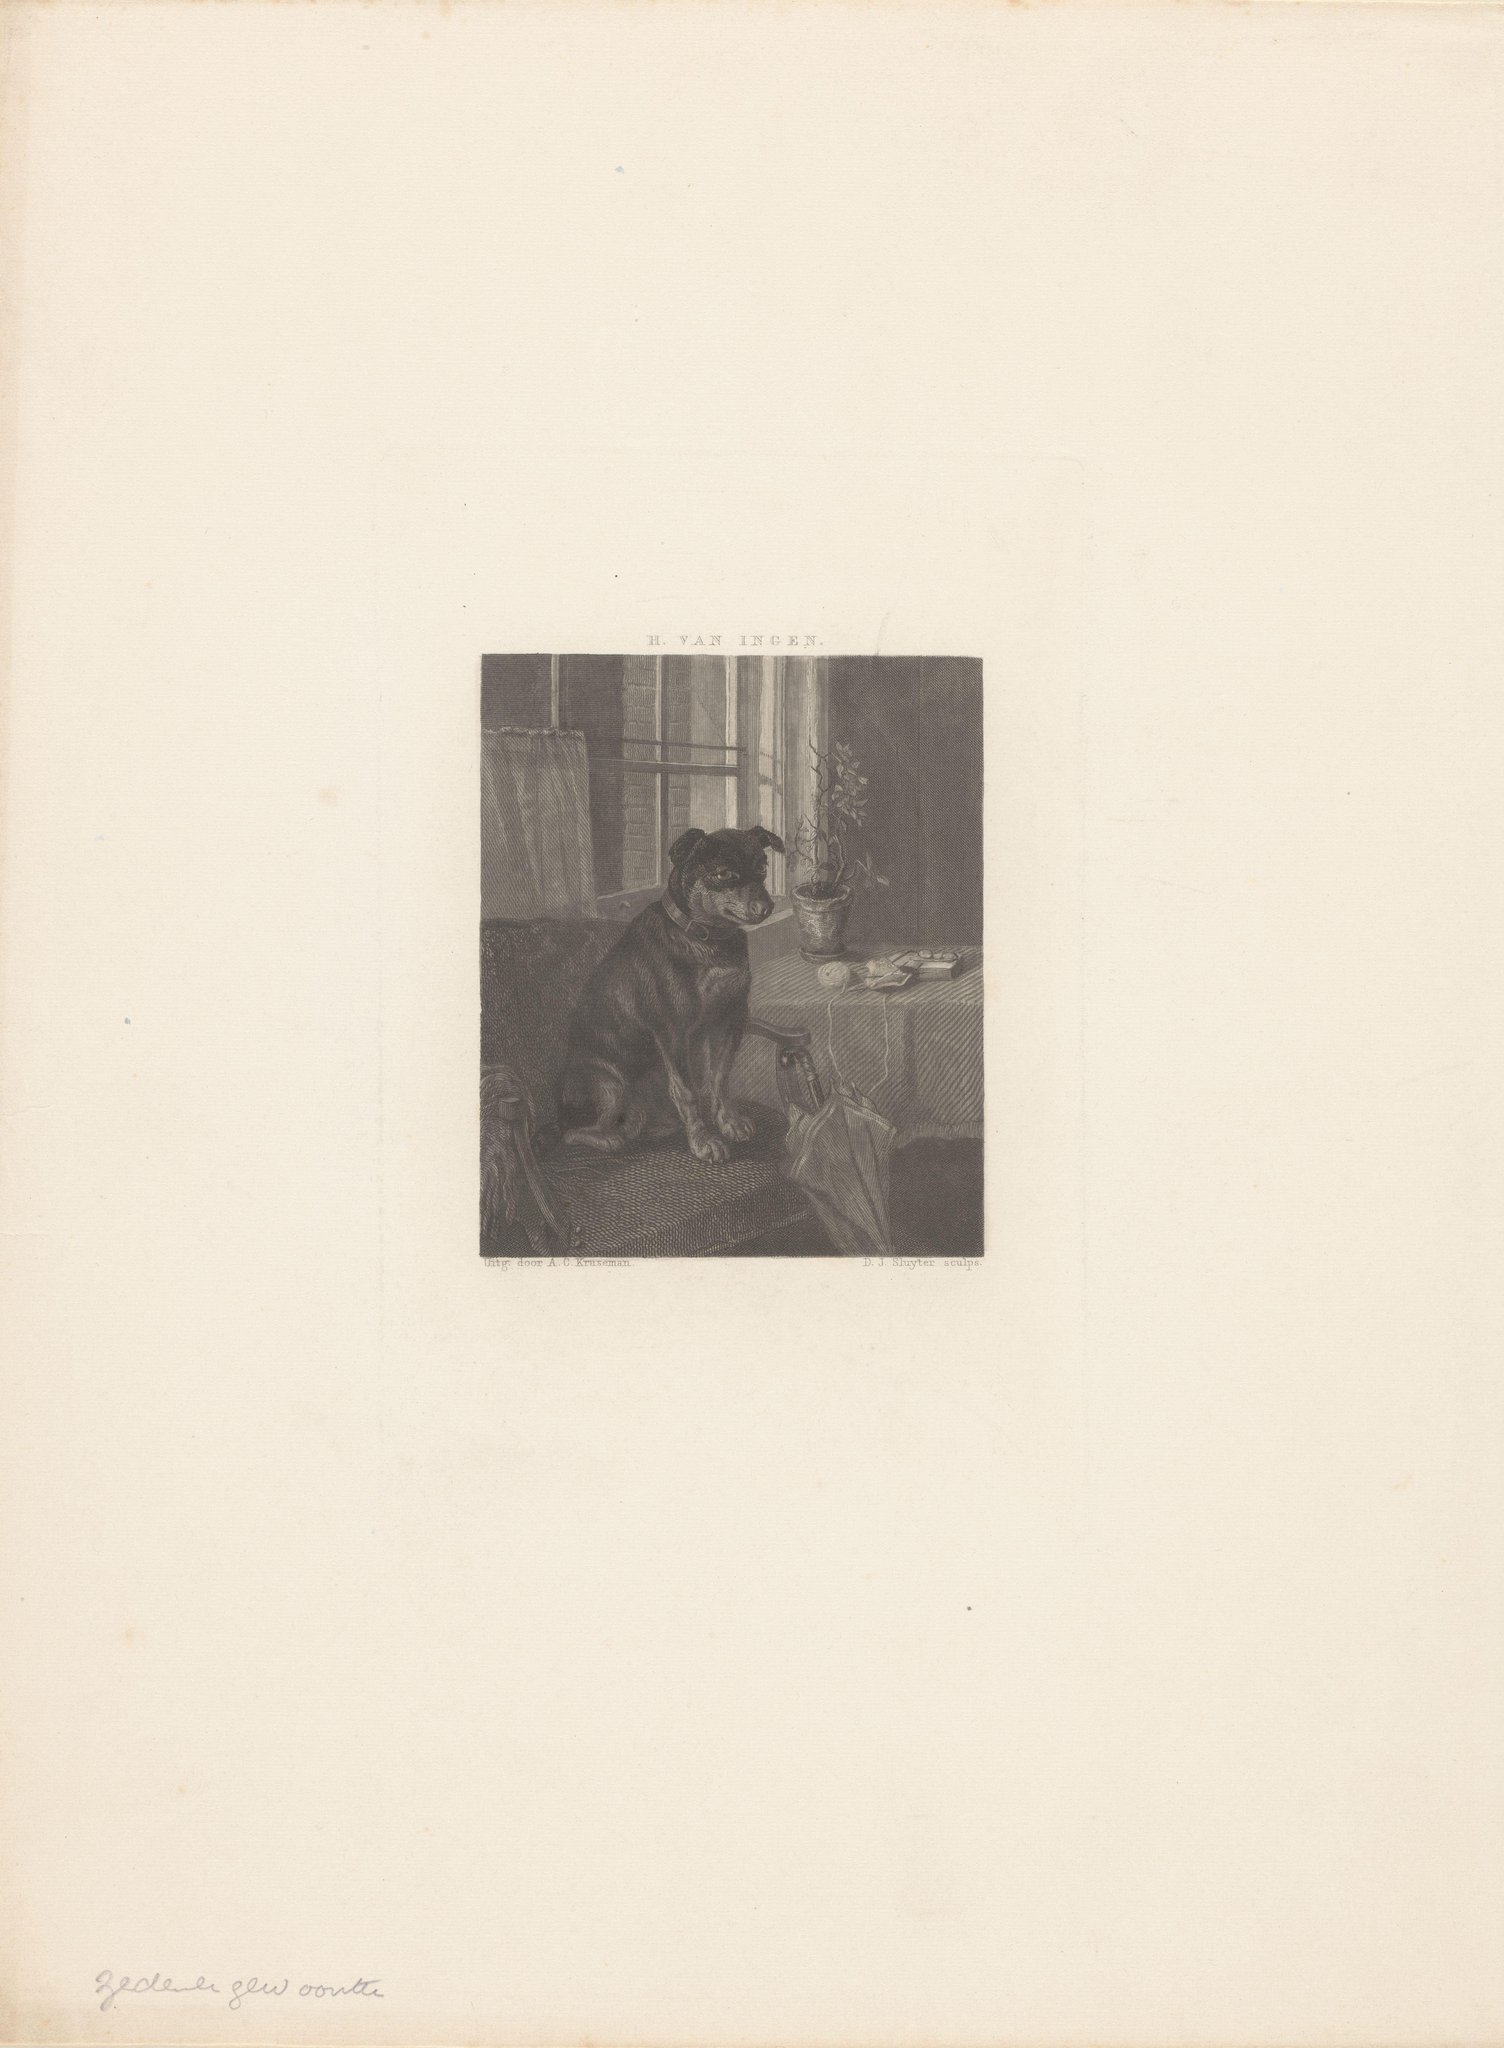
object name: print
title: Interieur met hond op een stoel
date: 1821-1886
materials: paper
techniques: aquatint, engraving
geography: amsterdam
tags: umbrella, knitting, dog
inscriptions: collector's mark: Lugt 2233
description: In een vertrek een tafel met plant. Naast de tafel een stoel waarop een hond zit. Tegen de stoel staat een paraplu.